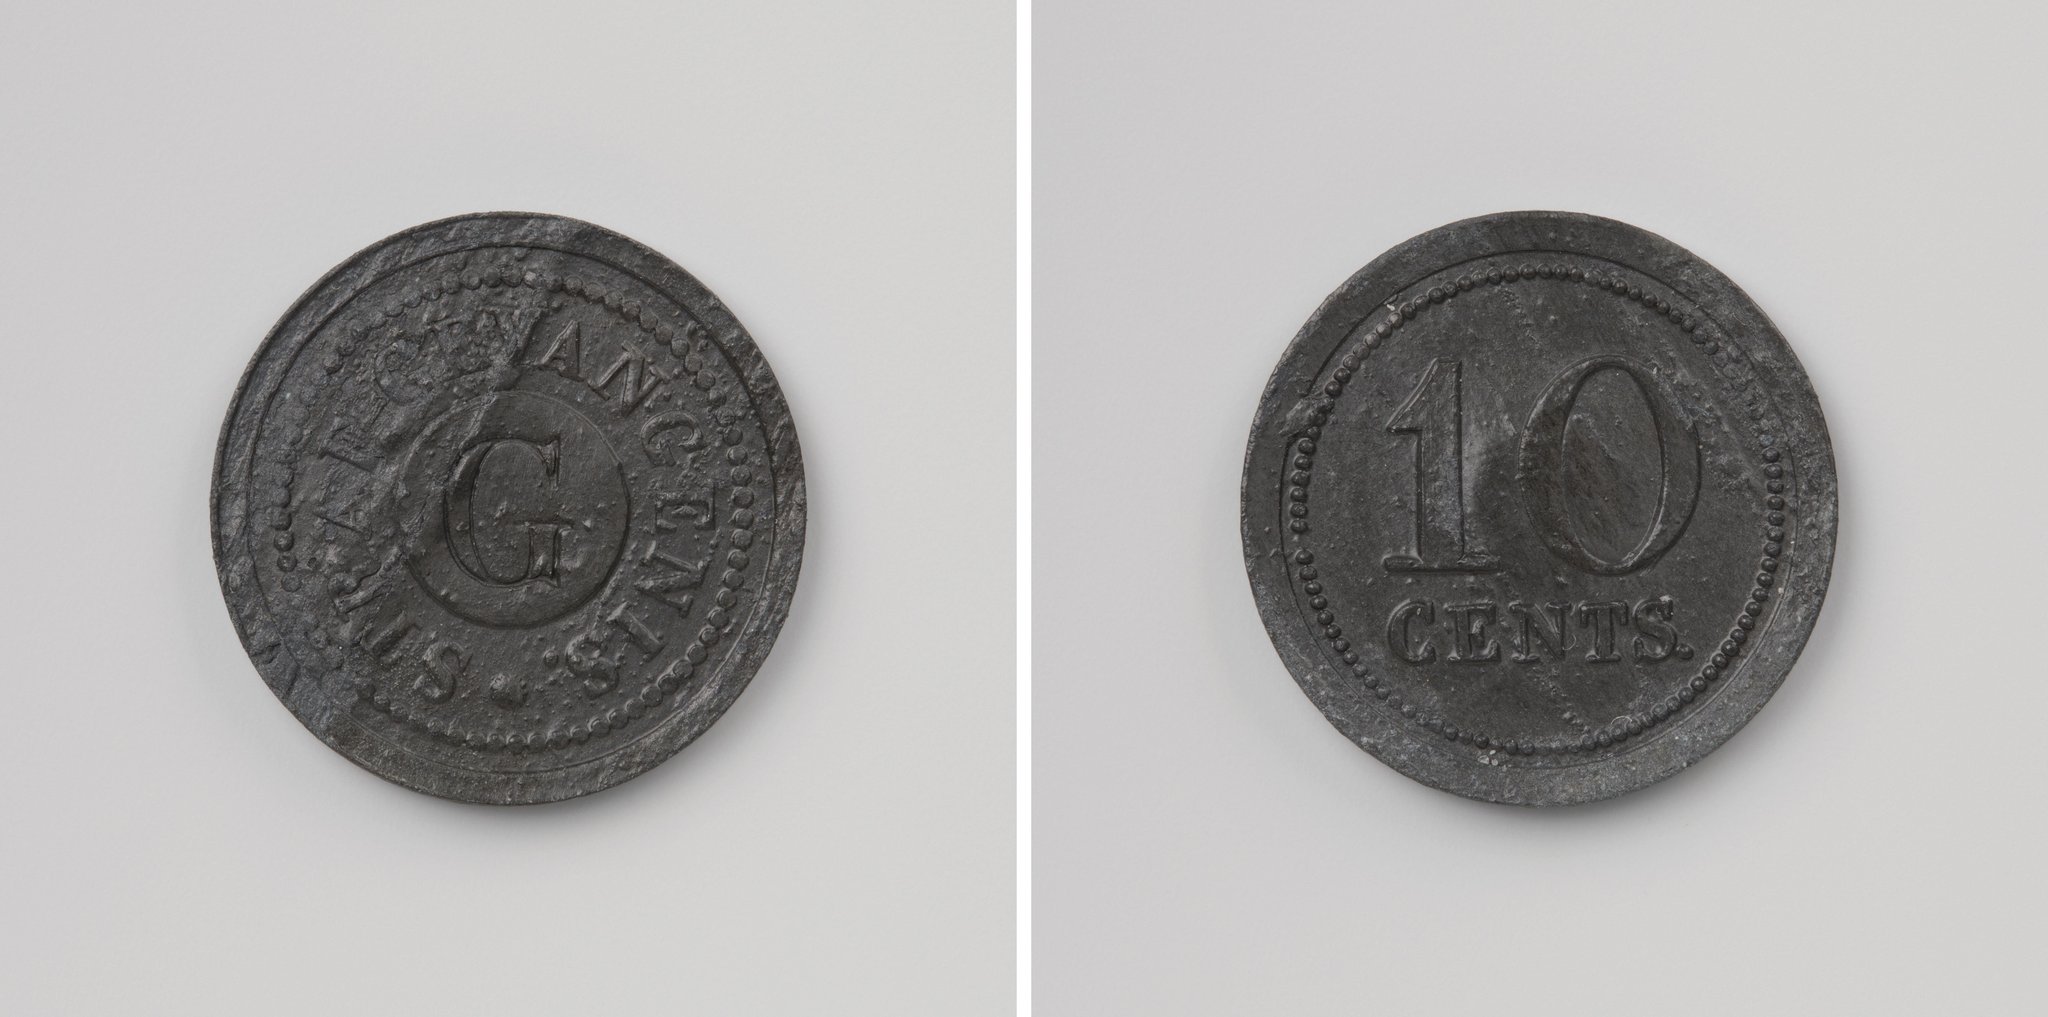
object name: tien cent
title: Strafgevangenis te Gouda, huismunt ter waarde van tien cent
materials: zinc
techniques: striking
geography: utrecht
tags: gouda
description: Zinken betaalpenning. Voorzijde: letter G binnen omschrift. Keerzijde: waardeaanduiding